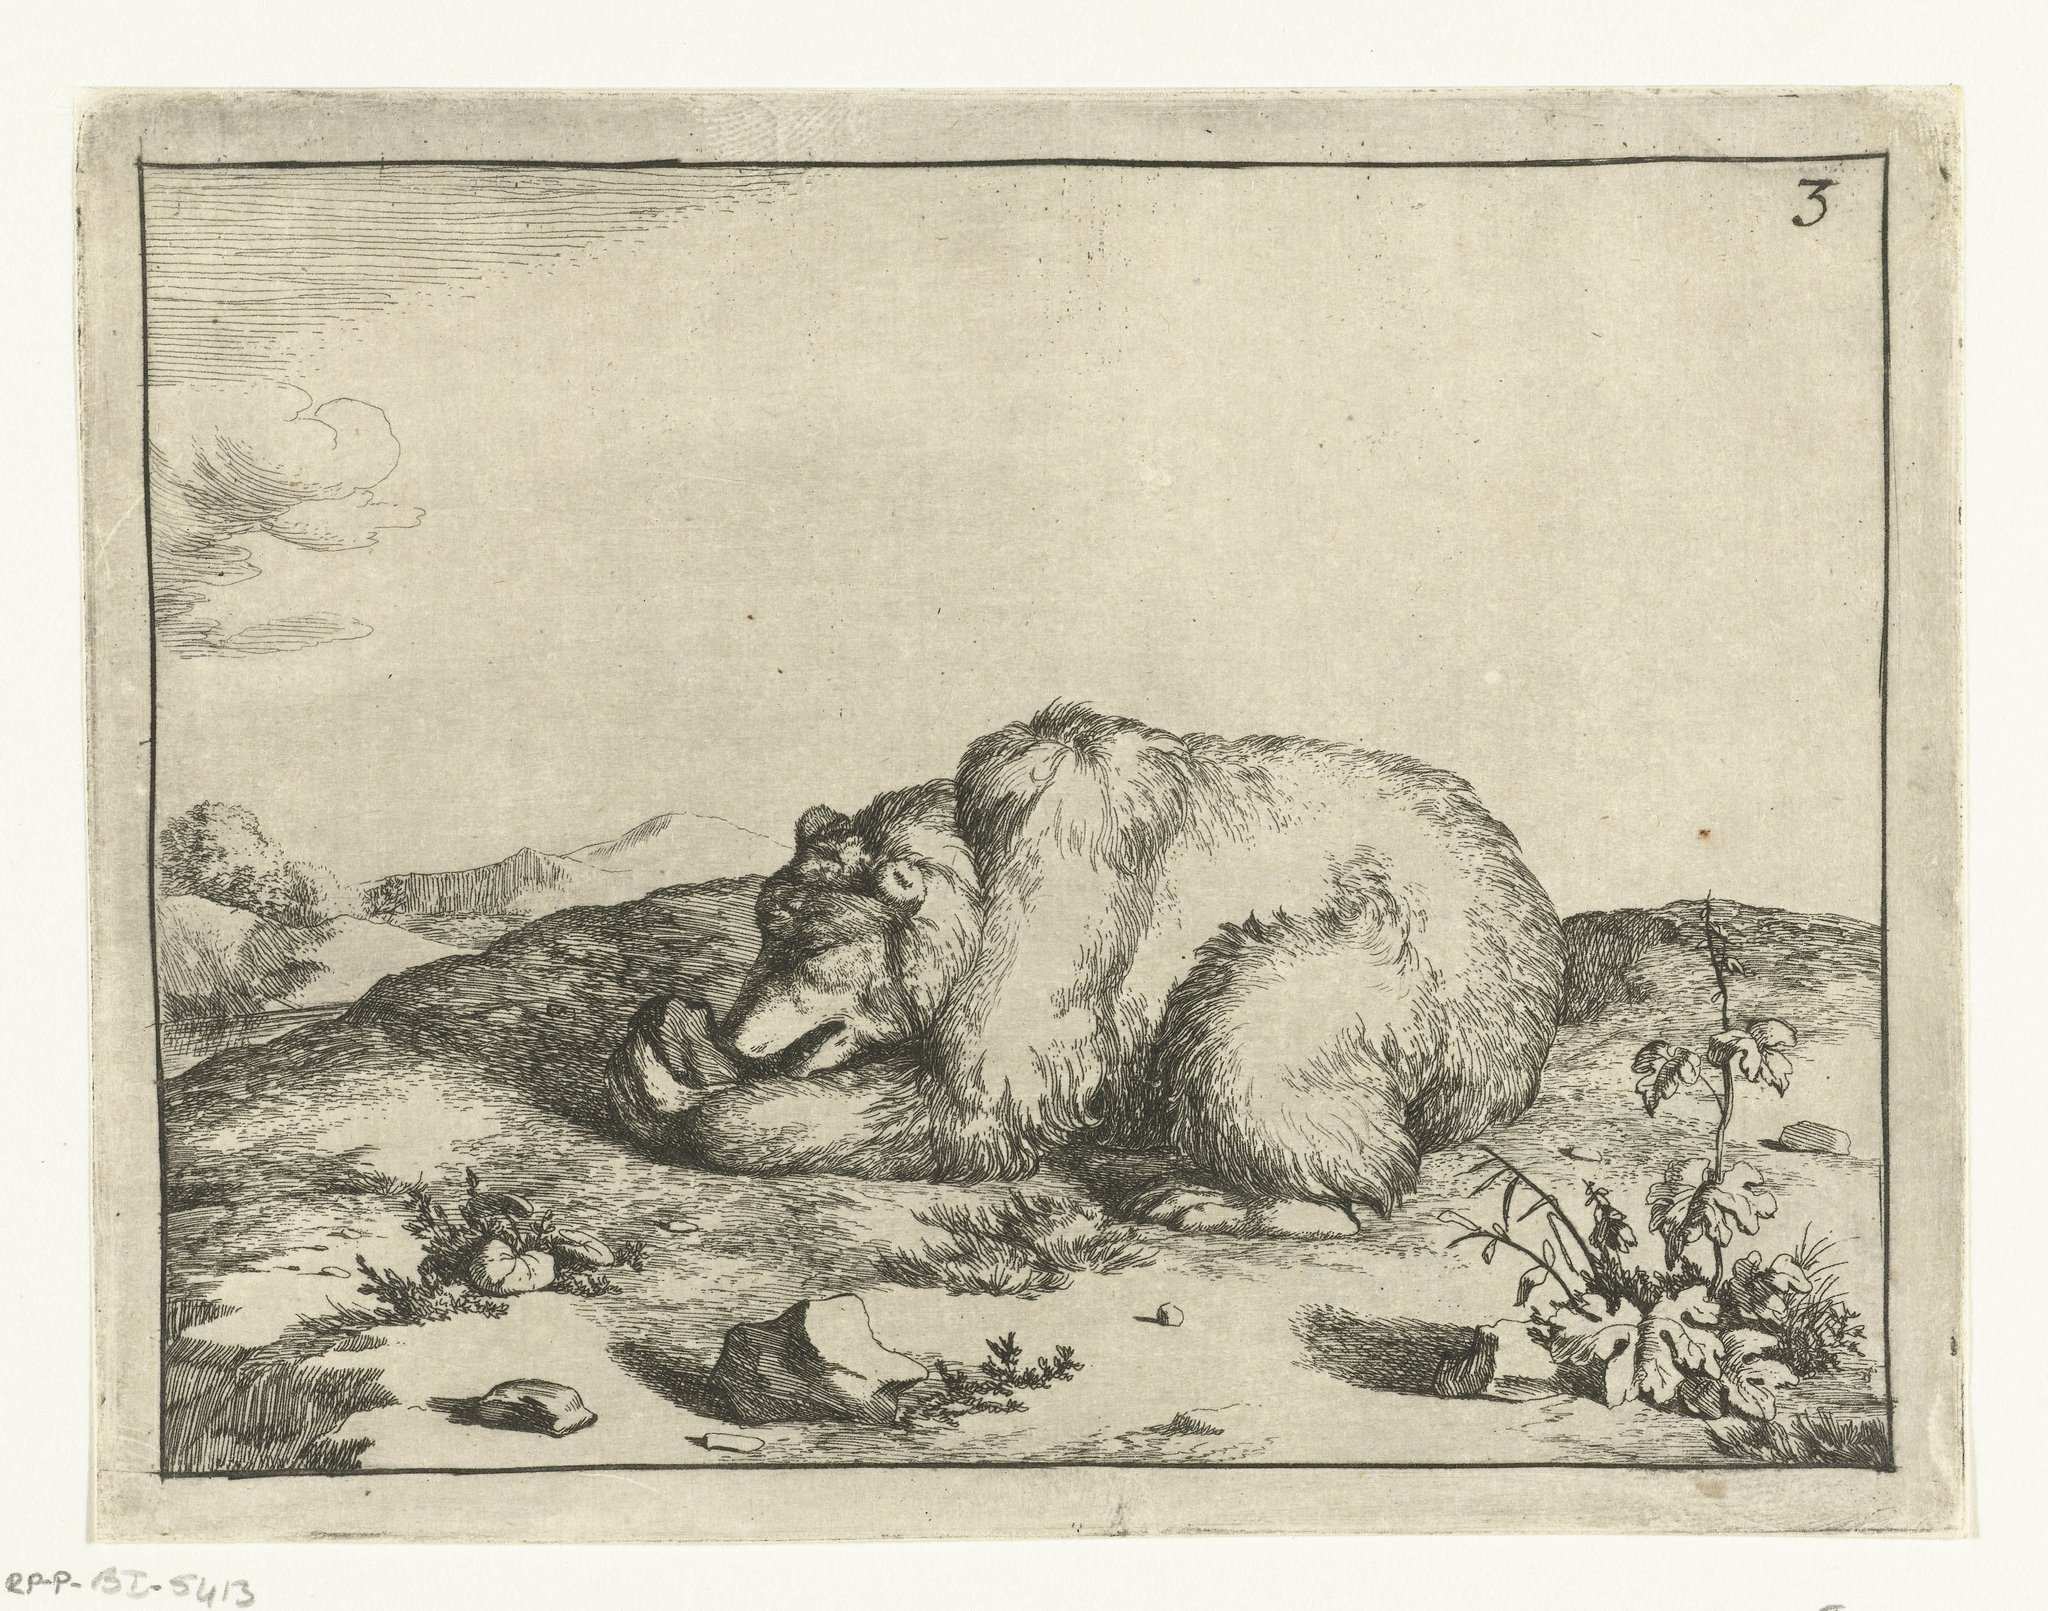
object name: print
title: Beren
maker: marcus de bye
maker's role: print maker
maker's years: 1639-1688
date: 1644-1664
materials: paper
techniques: etching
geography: the hague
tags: beasts of prey, predatory animals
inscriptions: collector's mark: Lugt 240